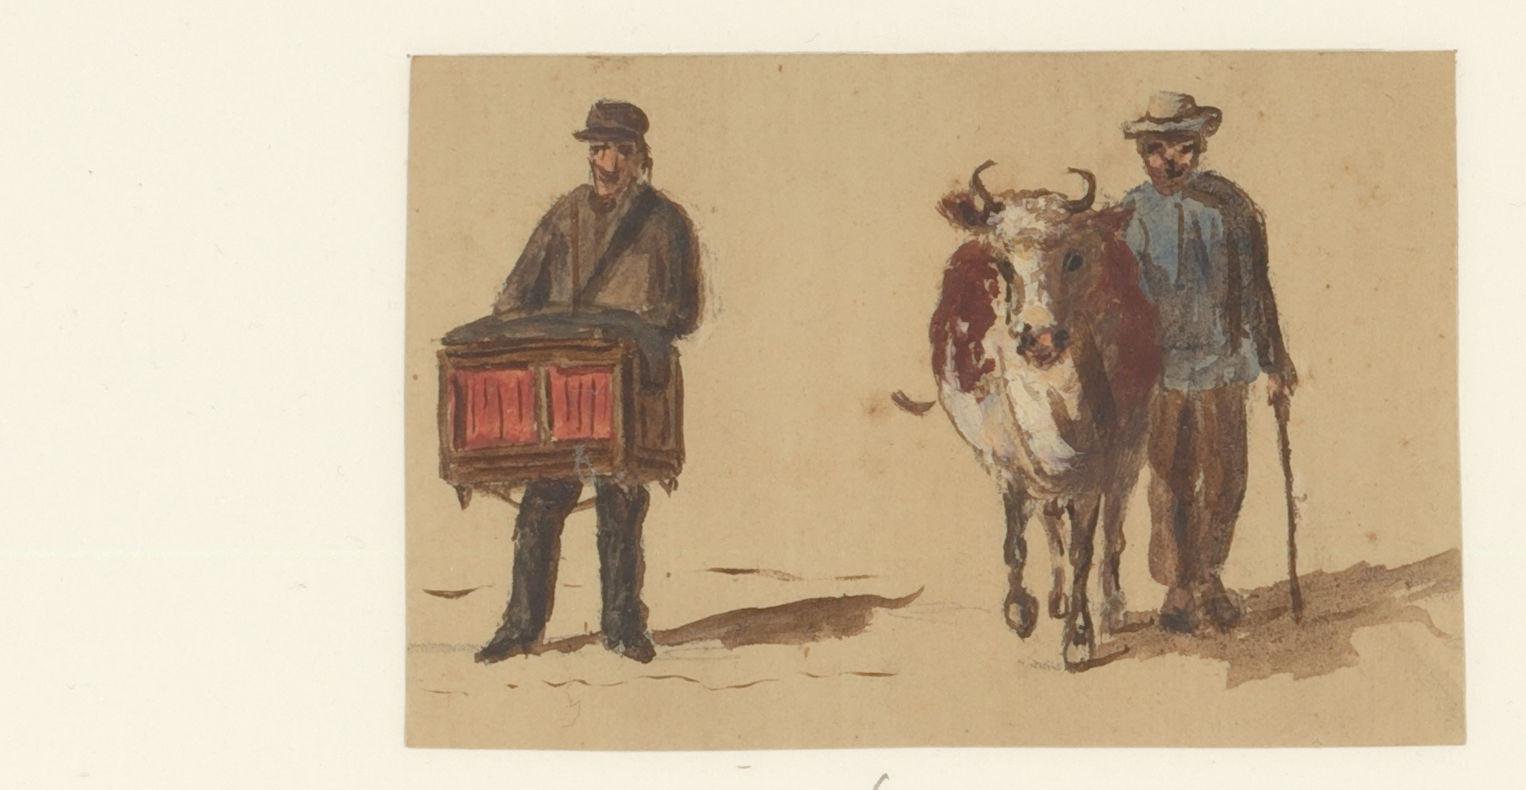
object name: drawing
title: Man met orgeltje en man met koe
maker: pierre jean fardon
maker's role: amateurschilder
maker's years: 1838-1911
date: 1850-1911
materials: chalk, paper, watercolor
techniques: brush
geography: netherlands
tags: cow, barrel-organ player, street-trader, amsterdam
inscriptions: collector's mark, collector's mark: Lugt 1641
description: Twee figuren: een man draagt een orgeltje op zijn buik en een man met een koe. Onderdeel van een serie van 16 bladen met tekeningen van Amsterdamse volkstypen. Onderwerpsrubrieken binnen de Atlas Zeden en Gewoonten: Mannelijk beroep en bedrijf: Marskramers, straatventers, straatslijpers, bedelaars, straatvertooningen enz.